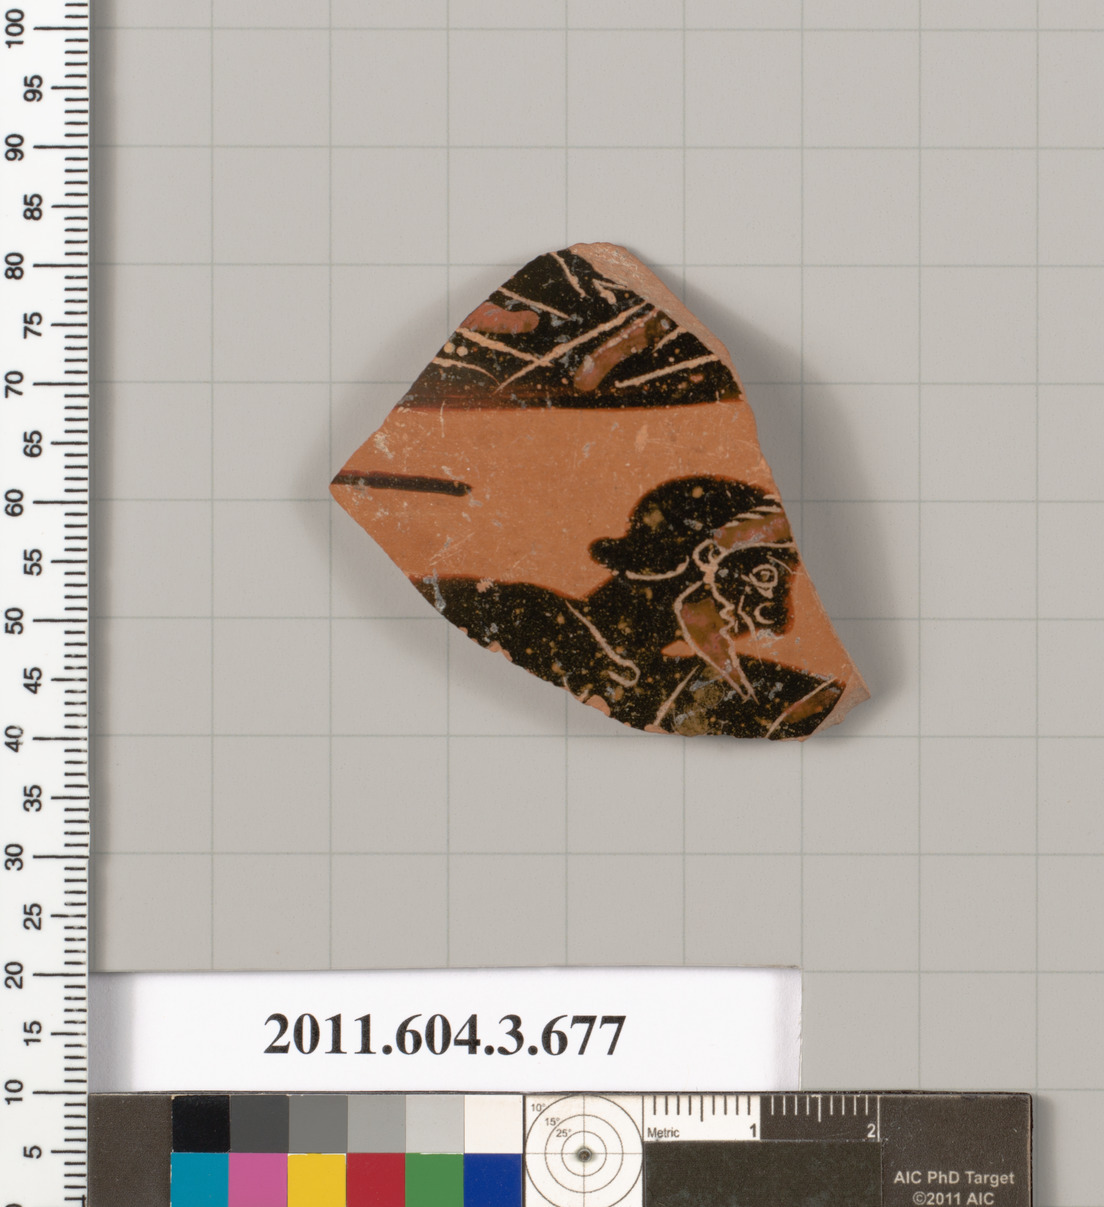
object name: stamnos fragment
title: Terracotta fragment of a stamnos (jar)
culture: greek, attic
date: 510-500 BCE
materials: terracotta